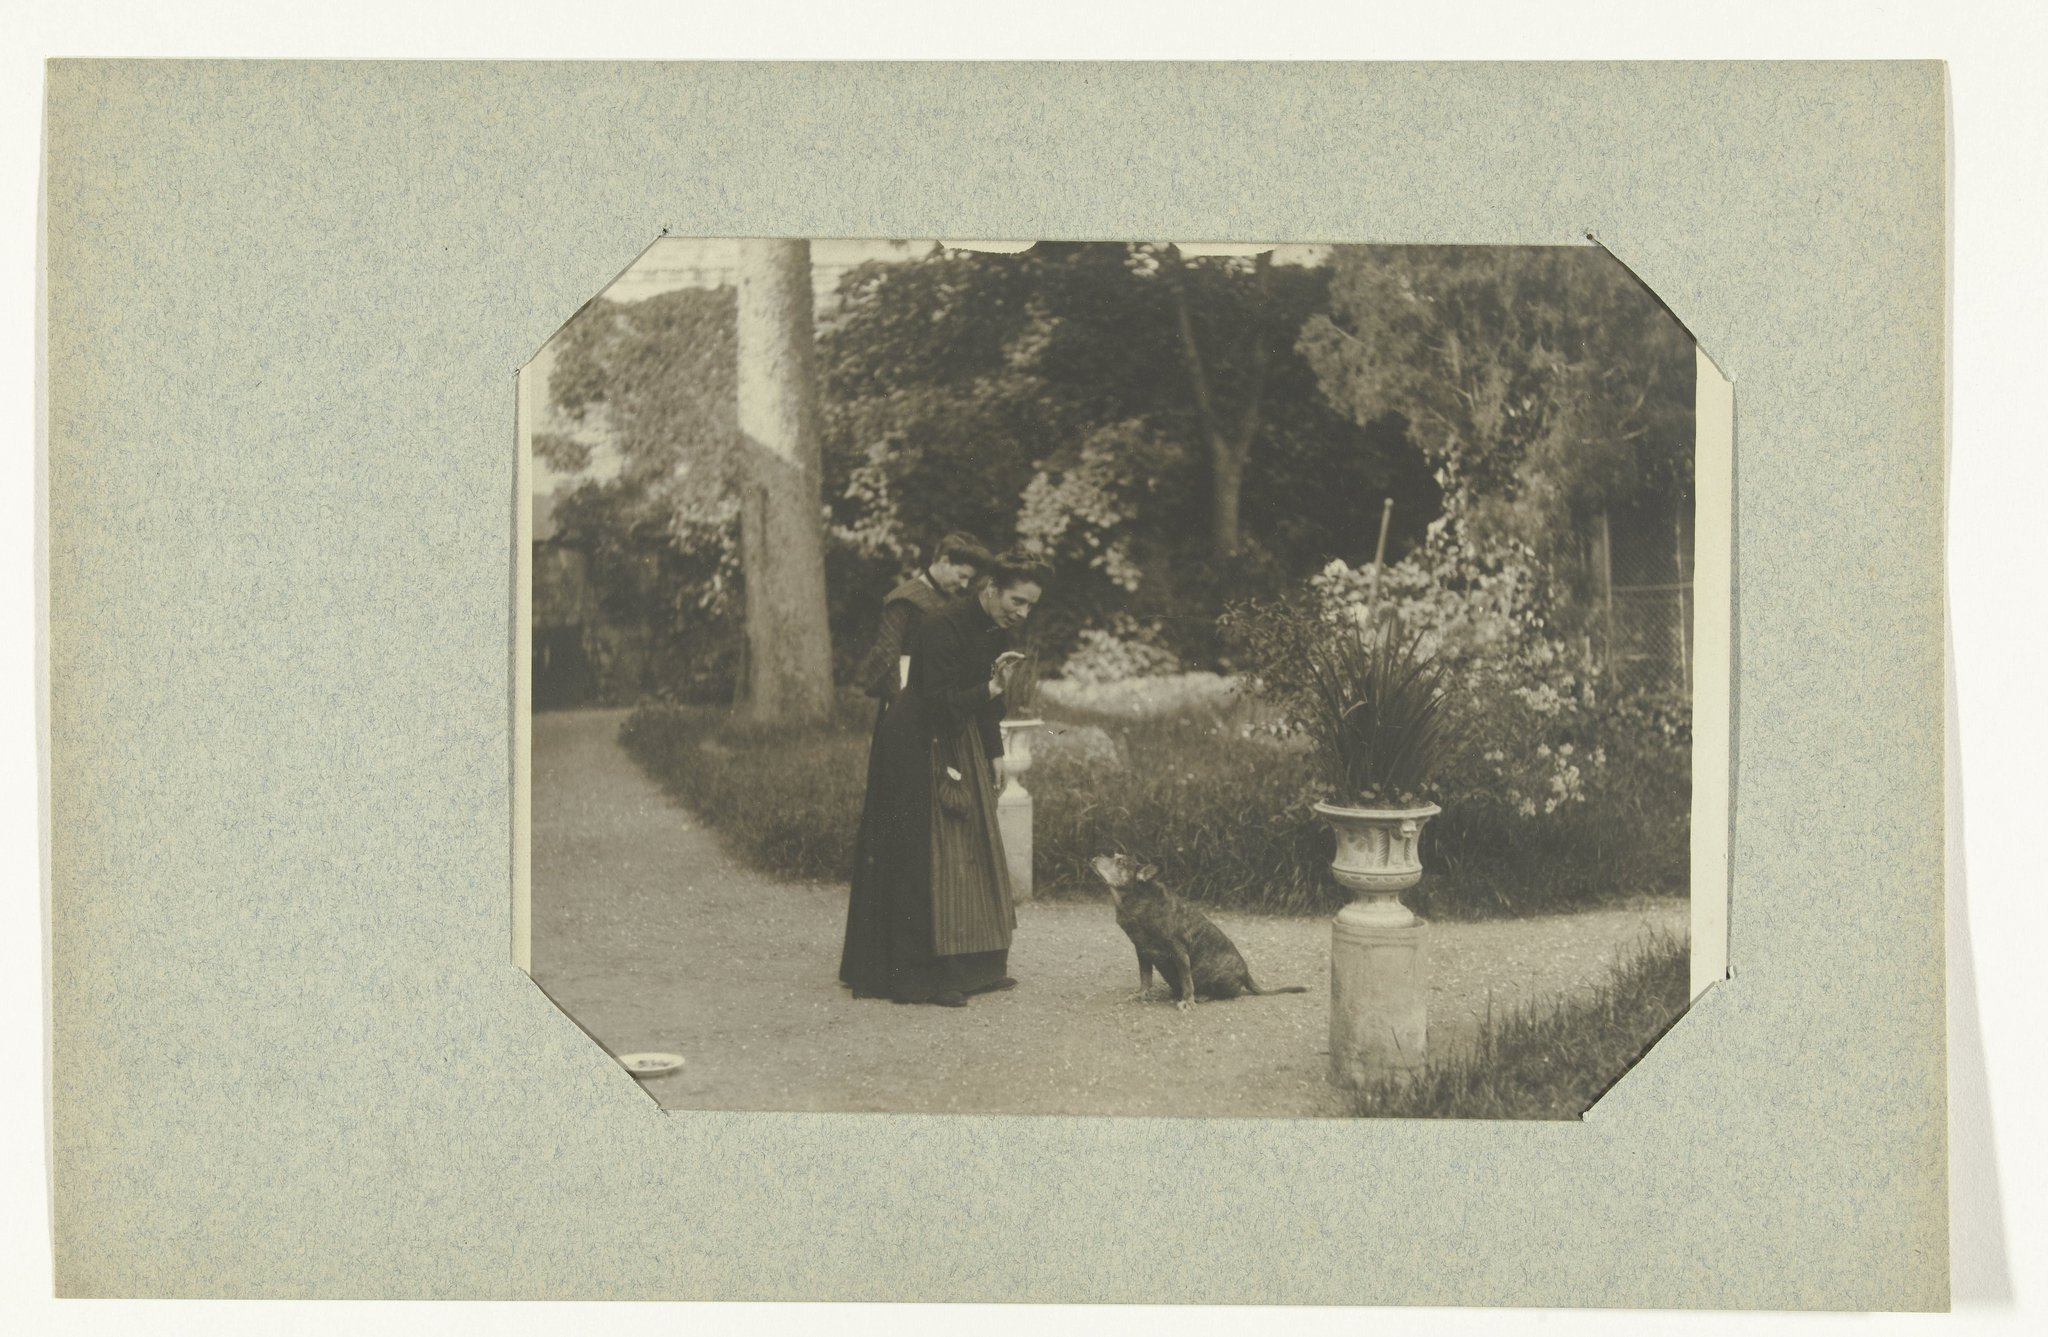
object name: photograph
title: Twee vrouwen en een hond in een tuin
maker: Anonymous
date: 1905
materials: paper, cardboard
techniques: gelatin silver print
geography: france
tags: adult woman, garden, dog, france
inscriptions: date: ‘28 mai/ 1905’, inscription: ‘Catalogue/ 714/ Guillement/ SF/ 6"/ S f 6"’